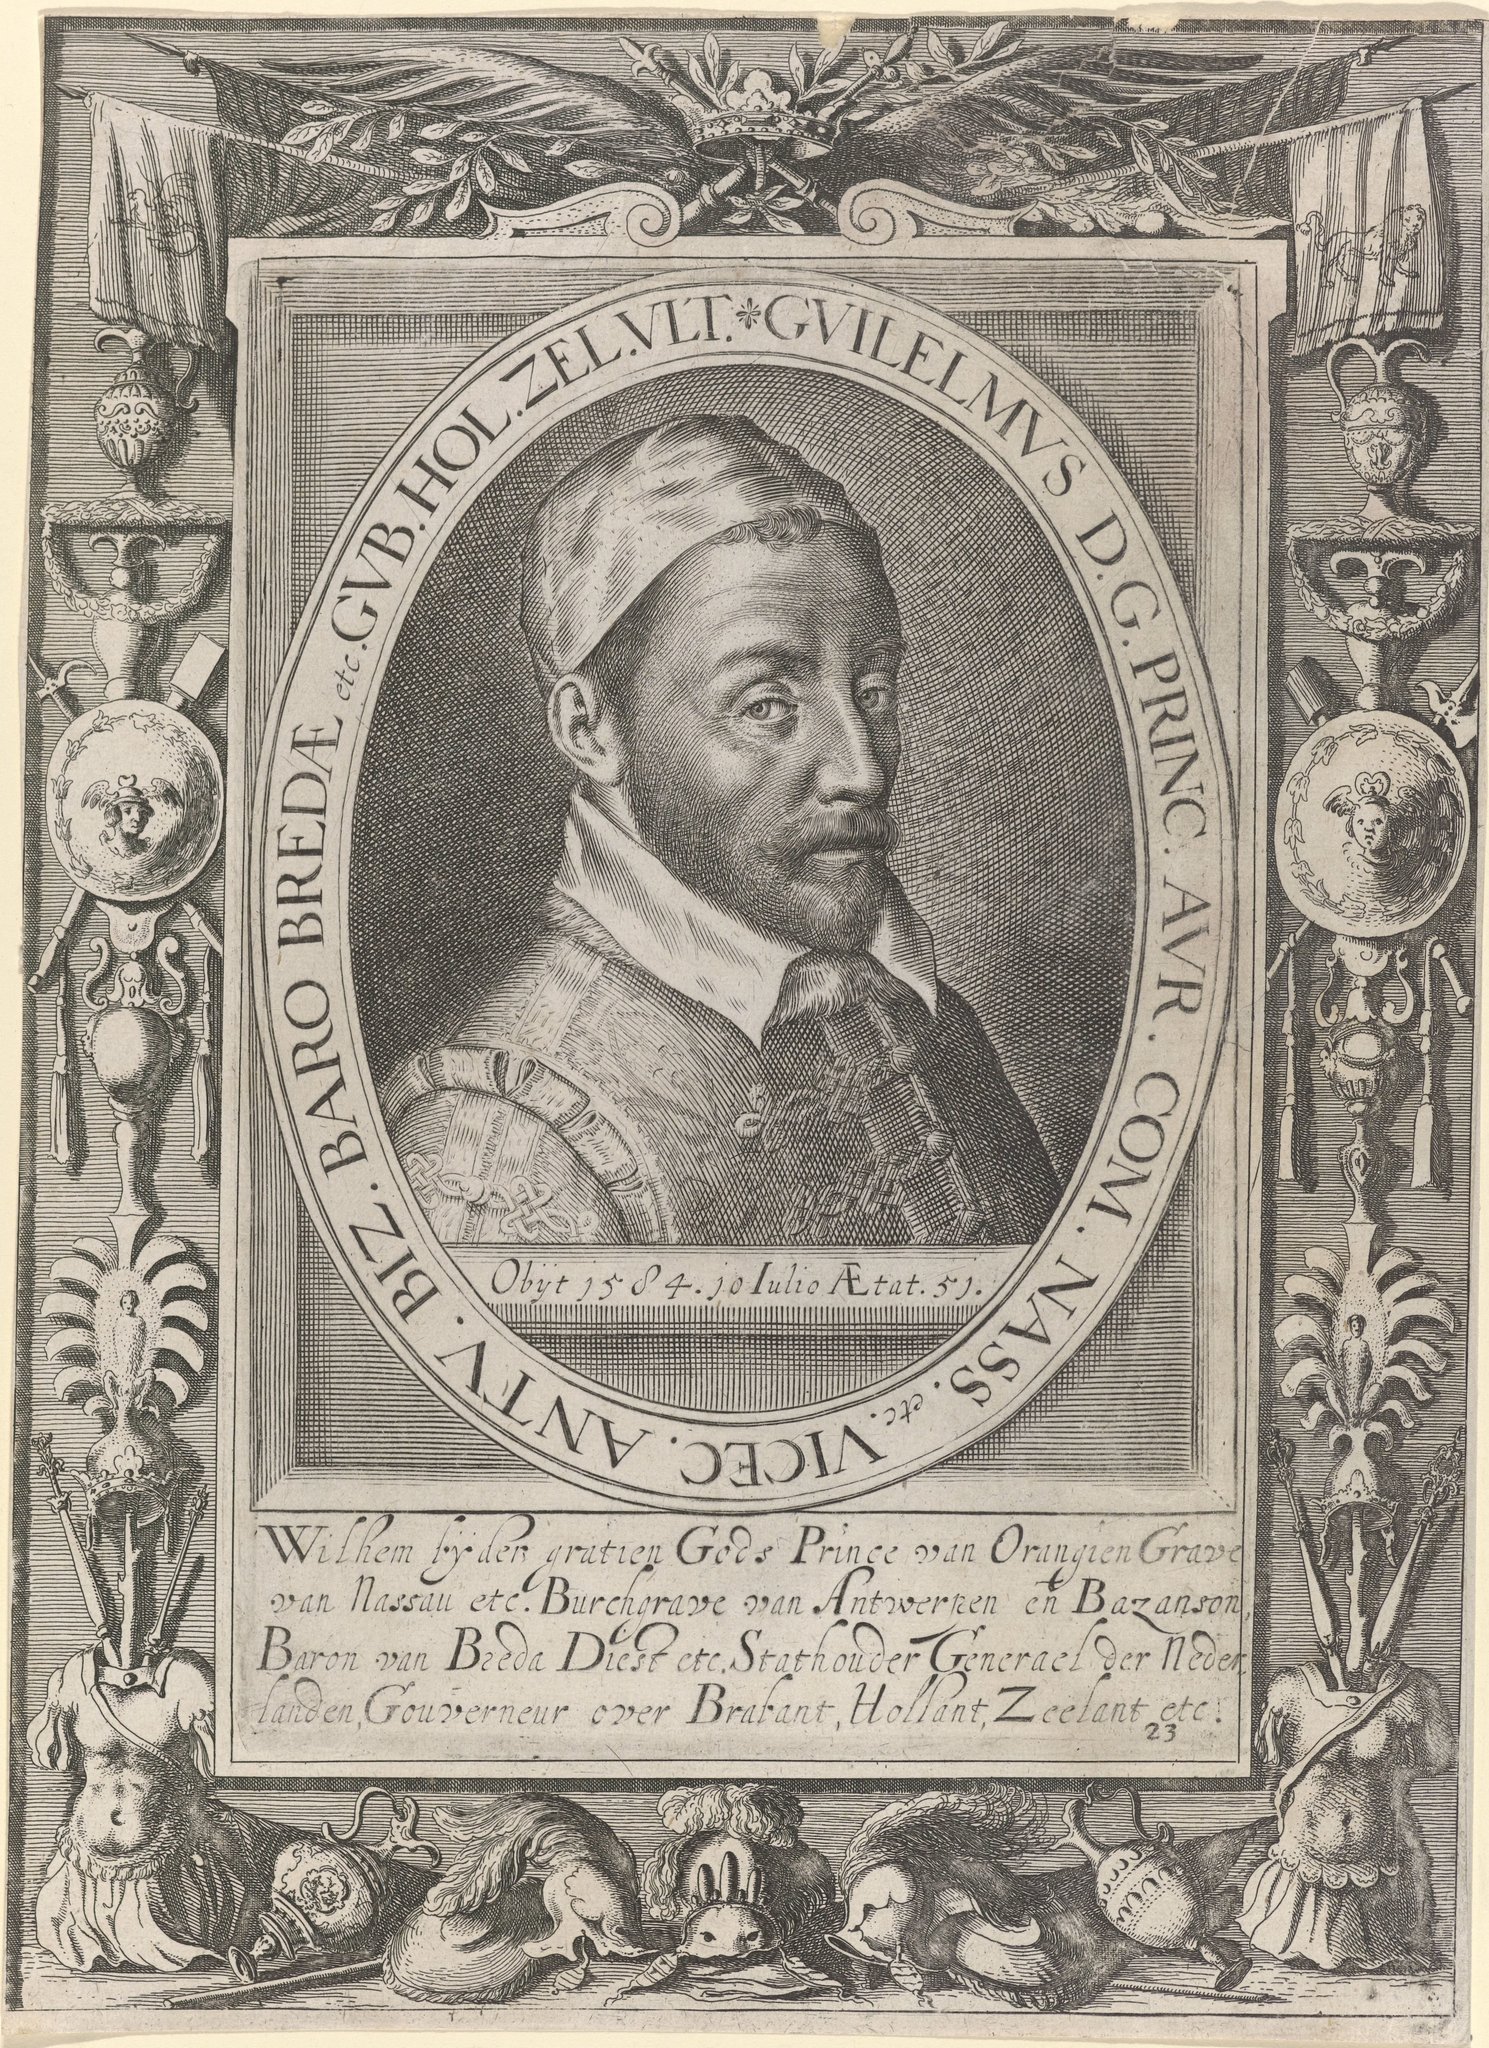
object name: print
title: Portret van Willem I, prins van Oranje, op 51-jarige leeftijd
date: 1640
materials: paper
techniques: engraving, etching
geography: low countries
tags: delft, william i (prince of orange)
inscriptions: collector's mark: Lugt 963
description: De hier vermelde titel verwijst naar de hoogst verkregen titel van de geportretteerde, niet per se naar de titel die de geportretteerde op deze voorstelling draagt. Prent uit: Meteren, Emanuel van. Niderlandische Historien. Amsterdam: Johannes Janssonius, 1640.